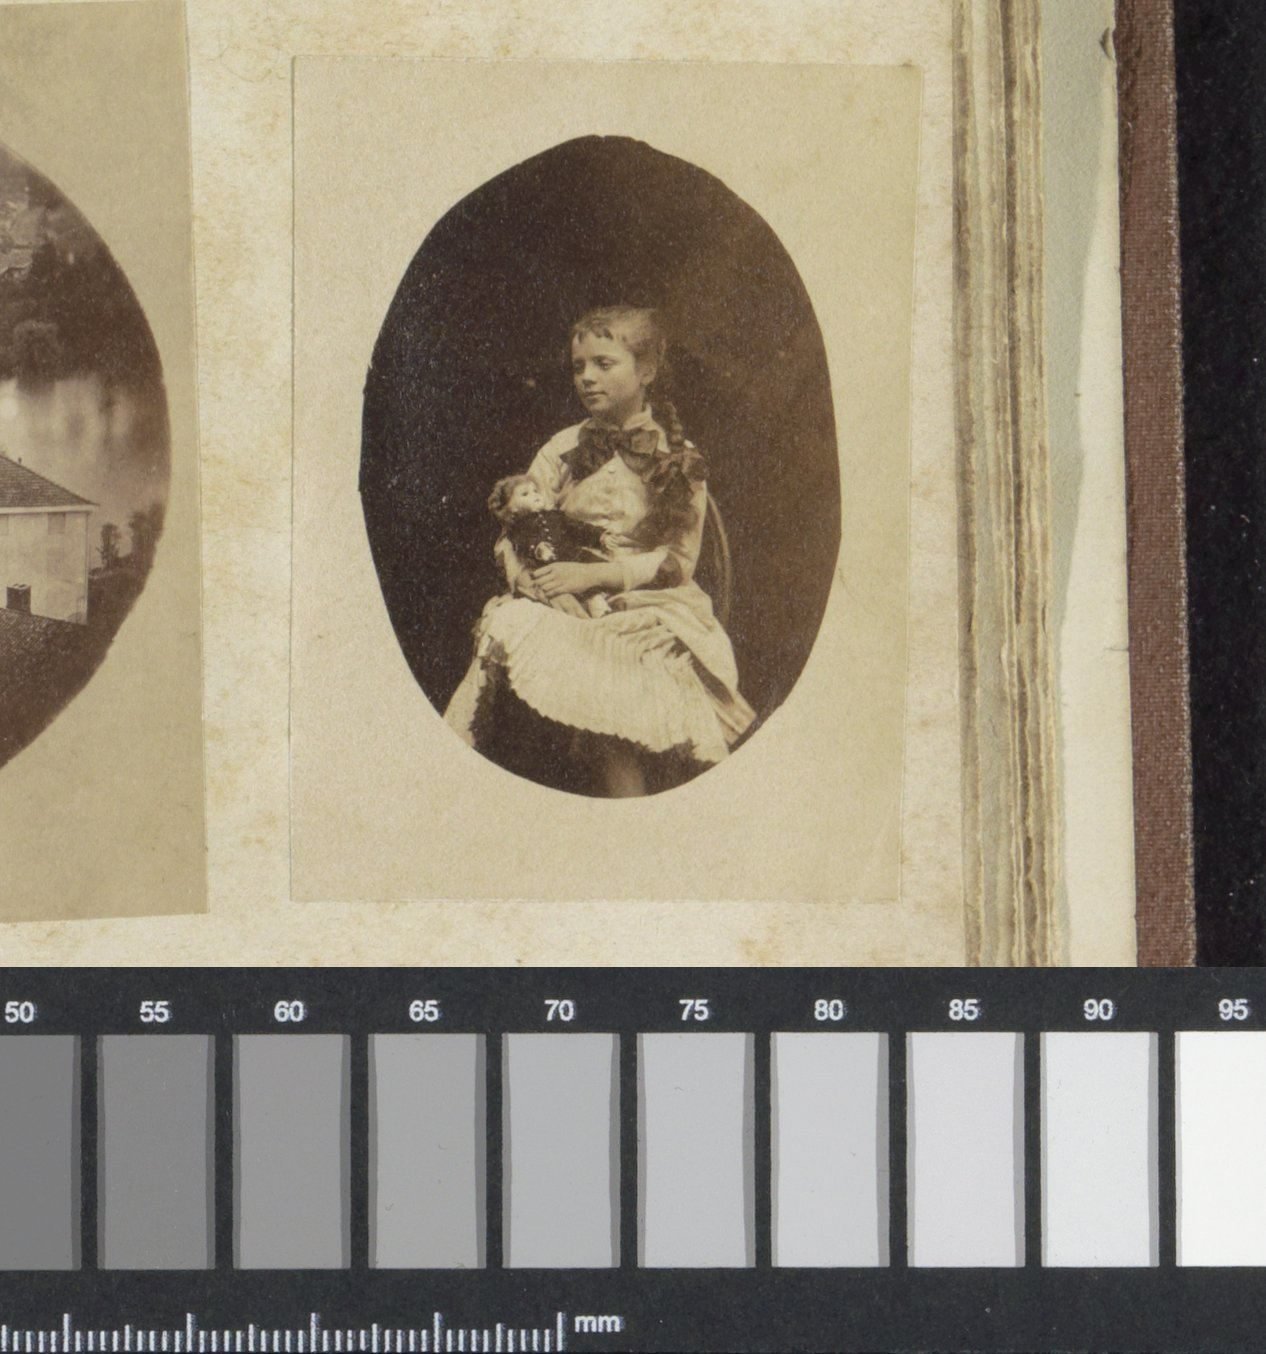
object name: photograph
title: Portret van een kind met een pop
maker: Anonymous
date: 1883-1886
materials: photographic support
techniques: albumen print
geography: france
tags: child, (playing with) dolls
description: Onderdeel van Album van een Franse amateurfotograaf met opnames van familie, militairen, industrie, landschappen en bezienswaardigheden in Frankrijk.